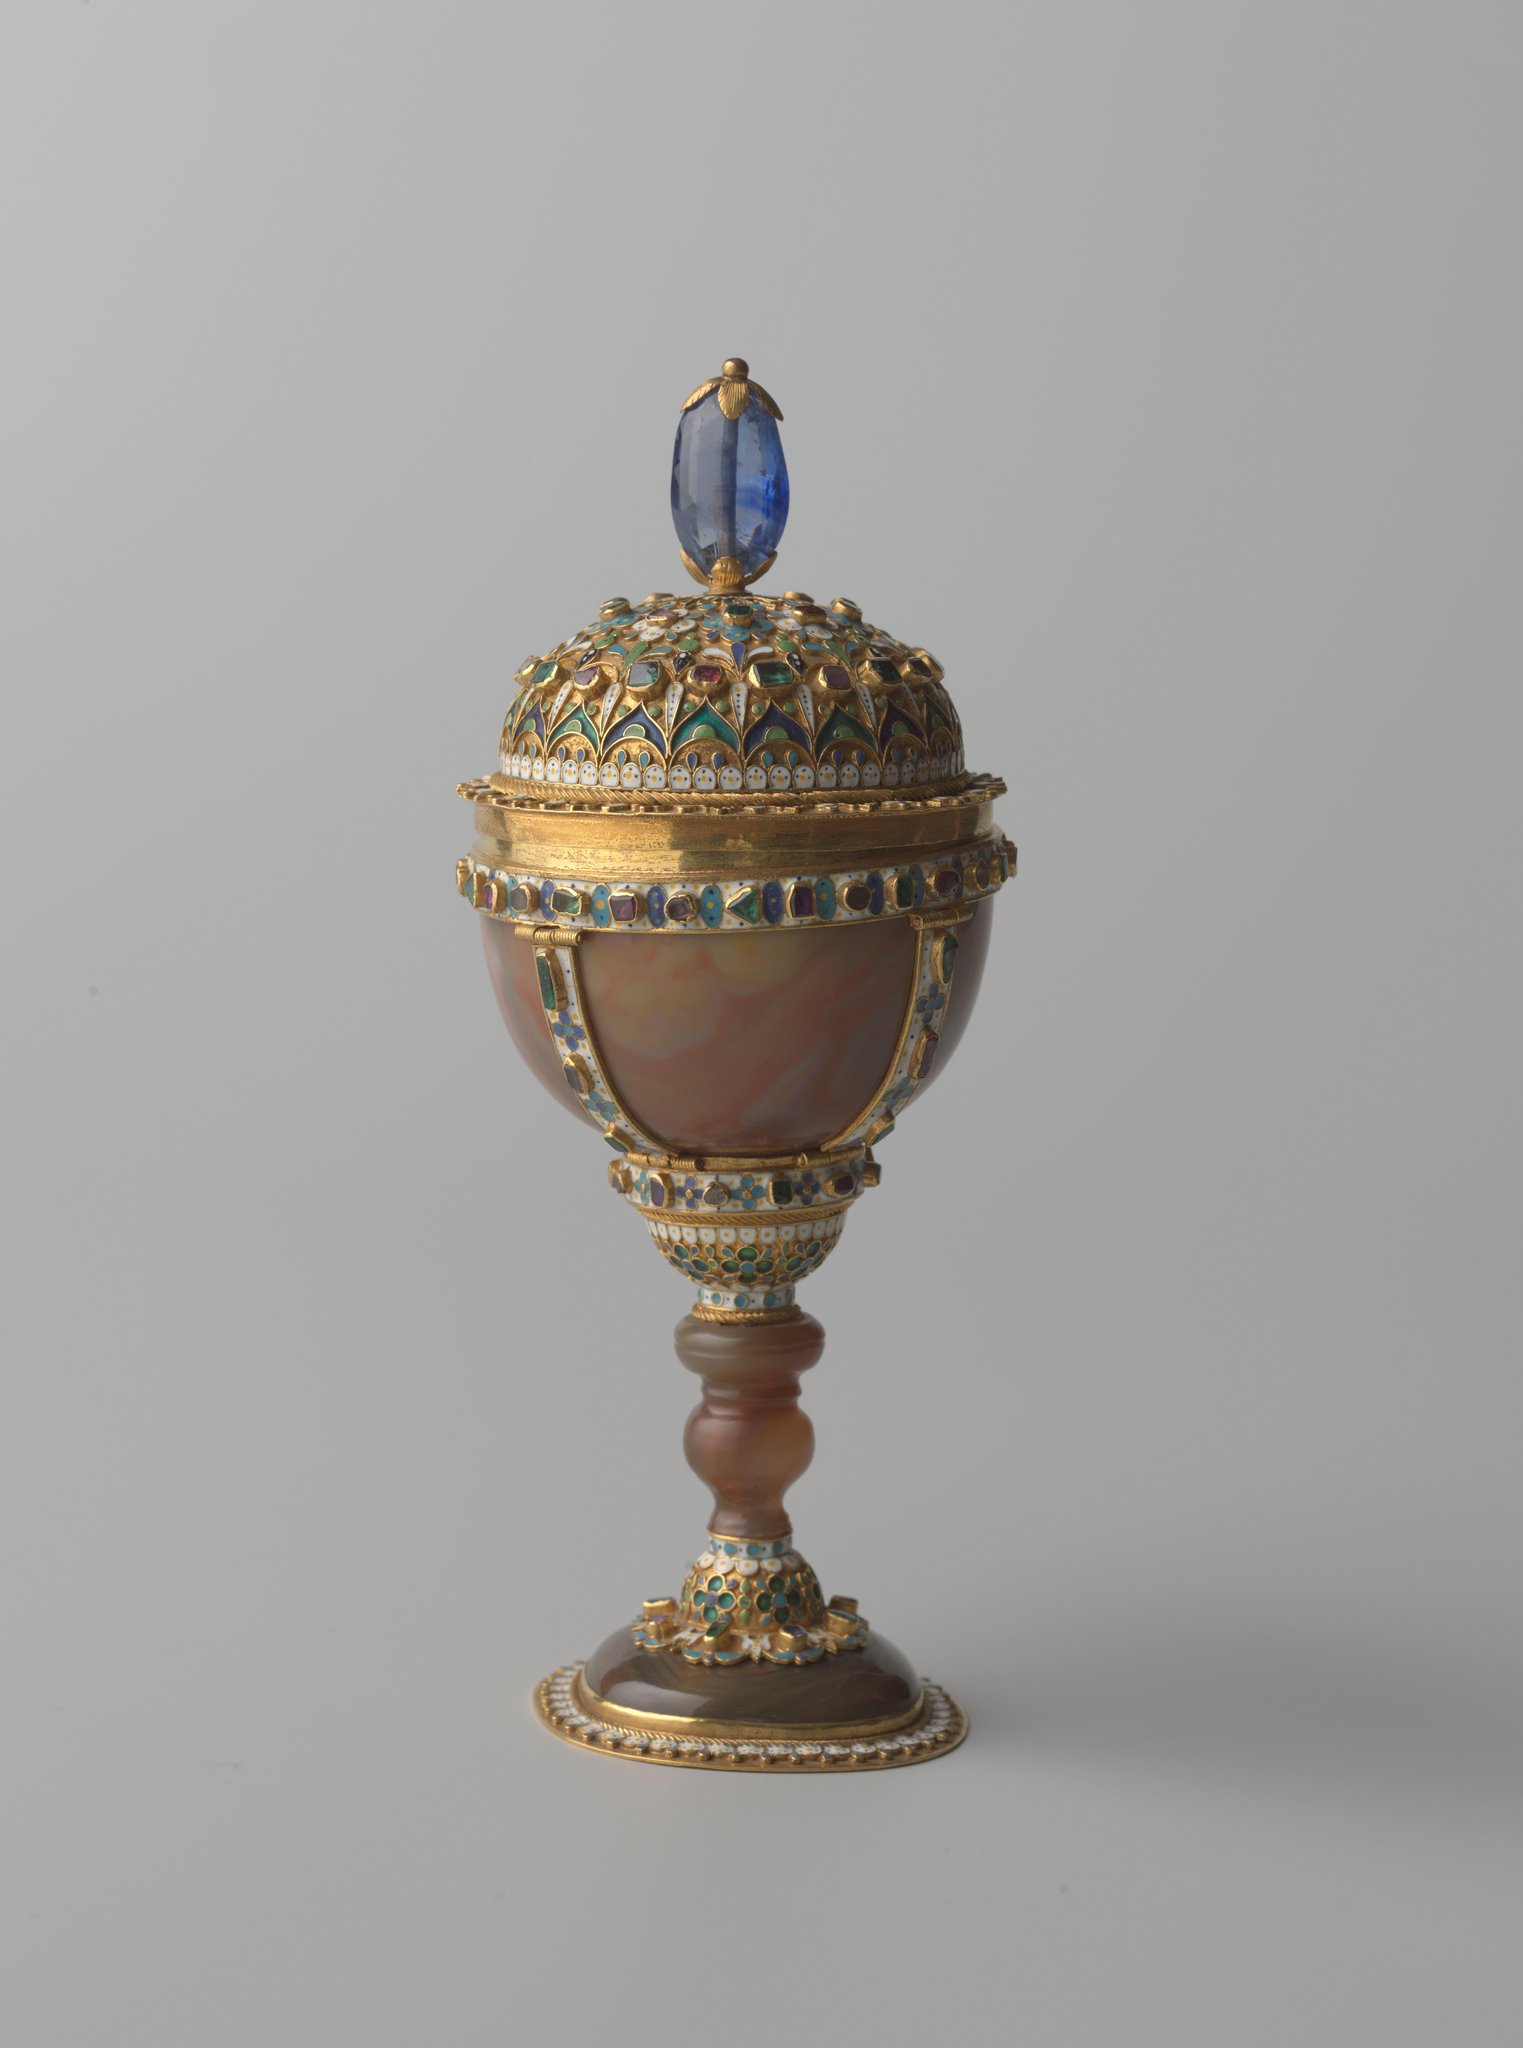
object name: lid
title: Coupe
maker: Anonymous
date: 1500-1600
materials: stone, gold, gemstone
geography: russia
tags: ornaments ~ art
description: Deksel van coupe. Als knop een geslepen safier.